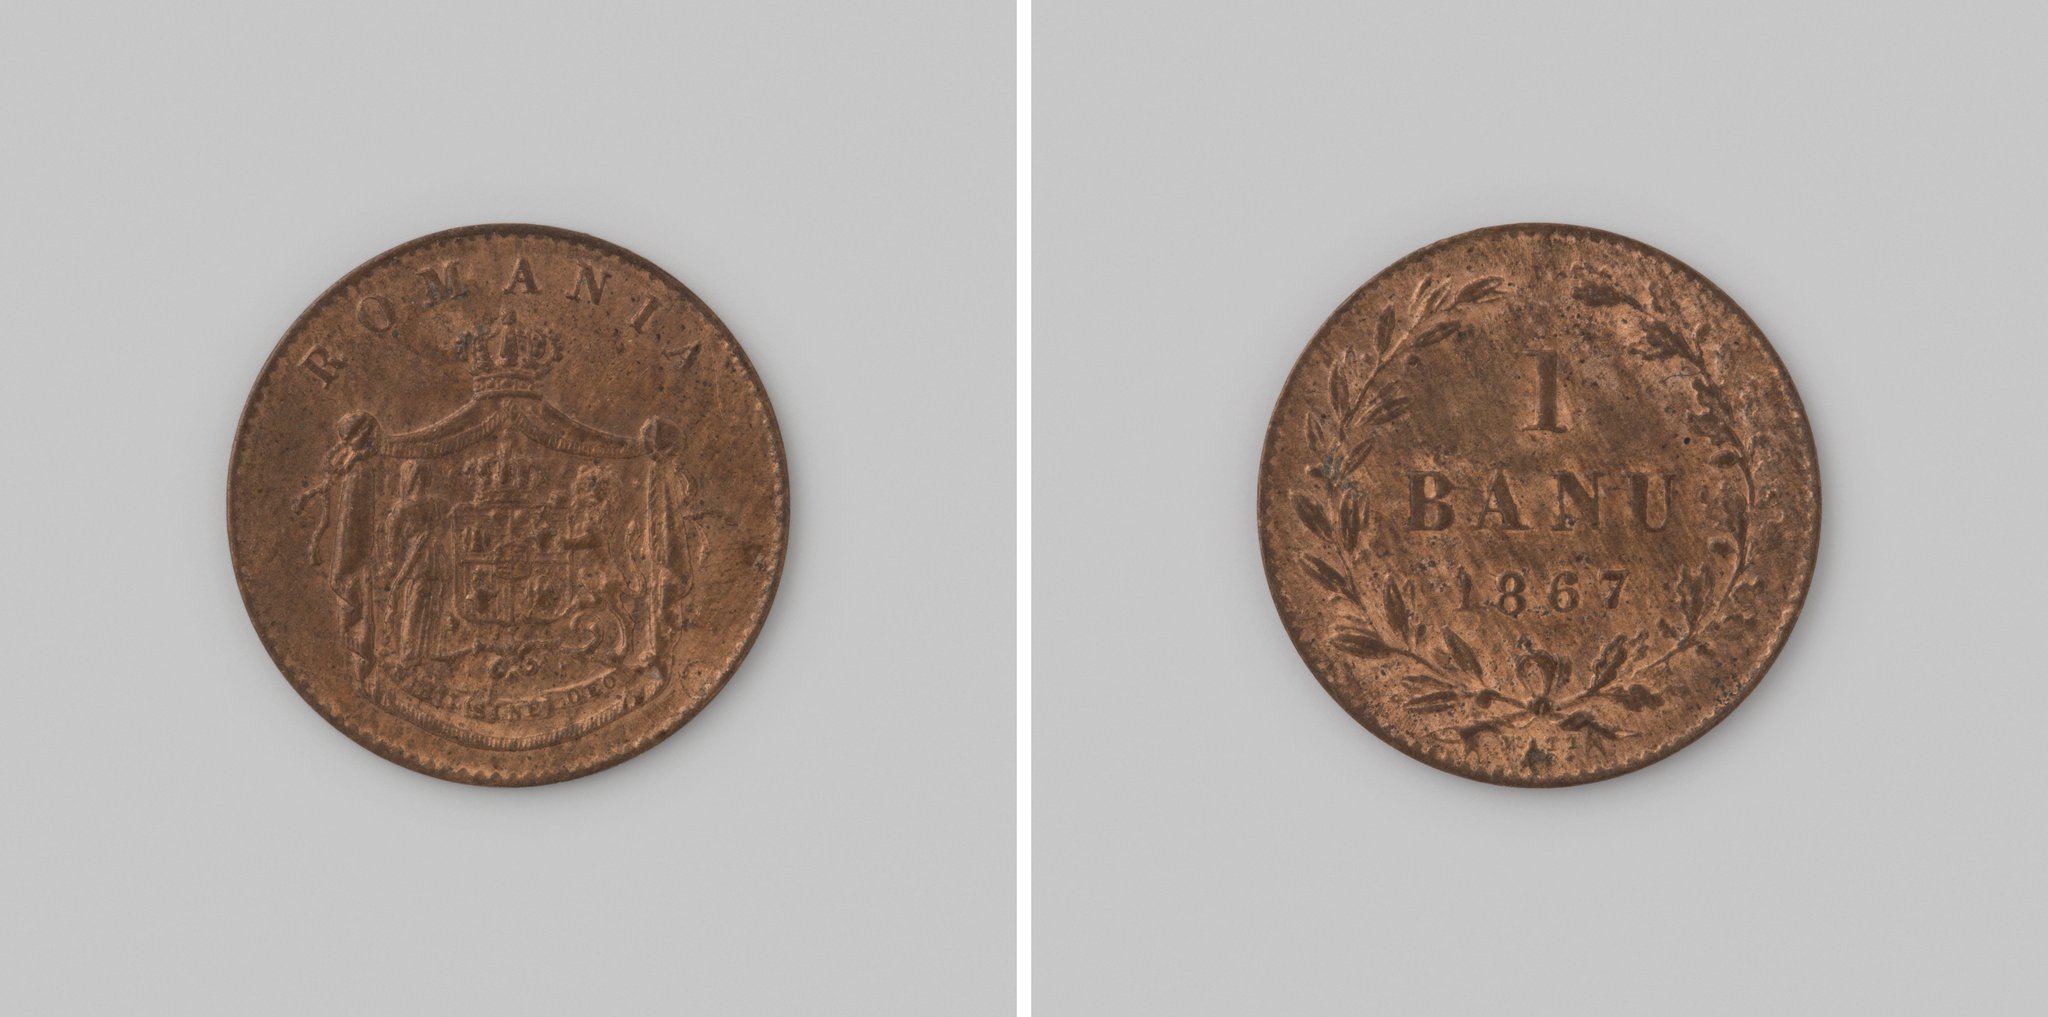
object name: coin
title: Roemenië, vorst Carol I, banu, 1867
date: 1867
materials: copper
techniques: striking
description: Koperen munt. Voorzijde: op een gekroonde wapenmantel een door twe schildhouders gehouden gekroond wapenschild, waaronder banderol met spreuk. Keerzijde: binnen twee samengebonden takken in twee regels waarde-aanduiding, waaronder jaartal. Gladde rand.